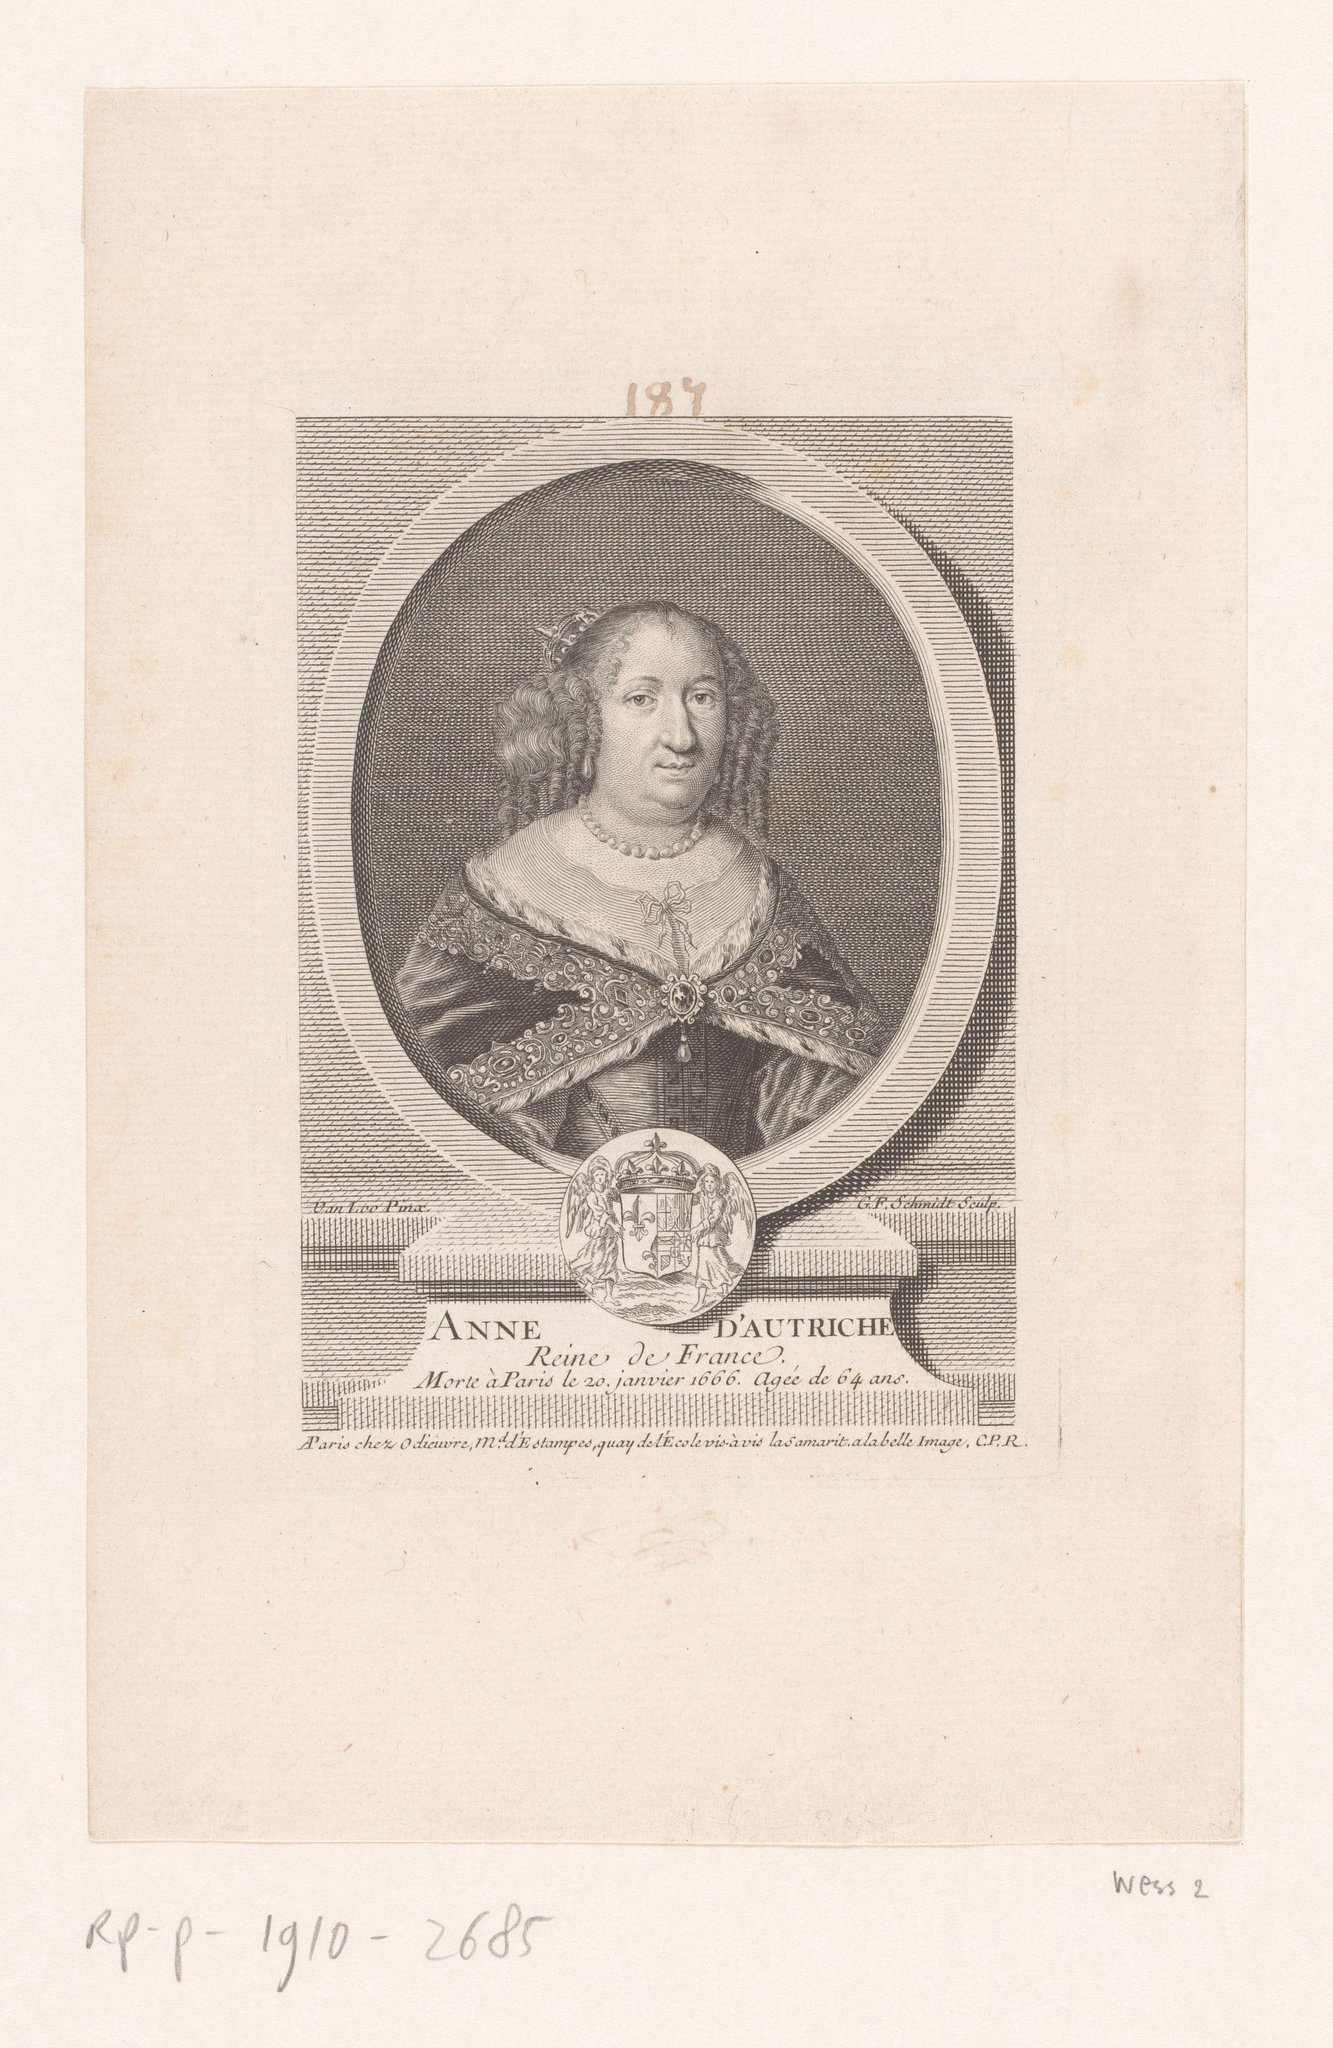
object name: print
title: Portret van Anna van Oostenrijk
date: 1722-1775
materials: paper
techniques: engraving, etching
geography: paris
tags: paris, anna van oostenrijk, historical persons - bb - woman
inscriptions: collector's mark: Lugt 2228